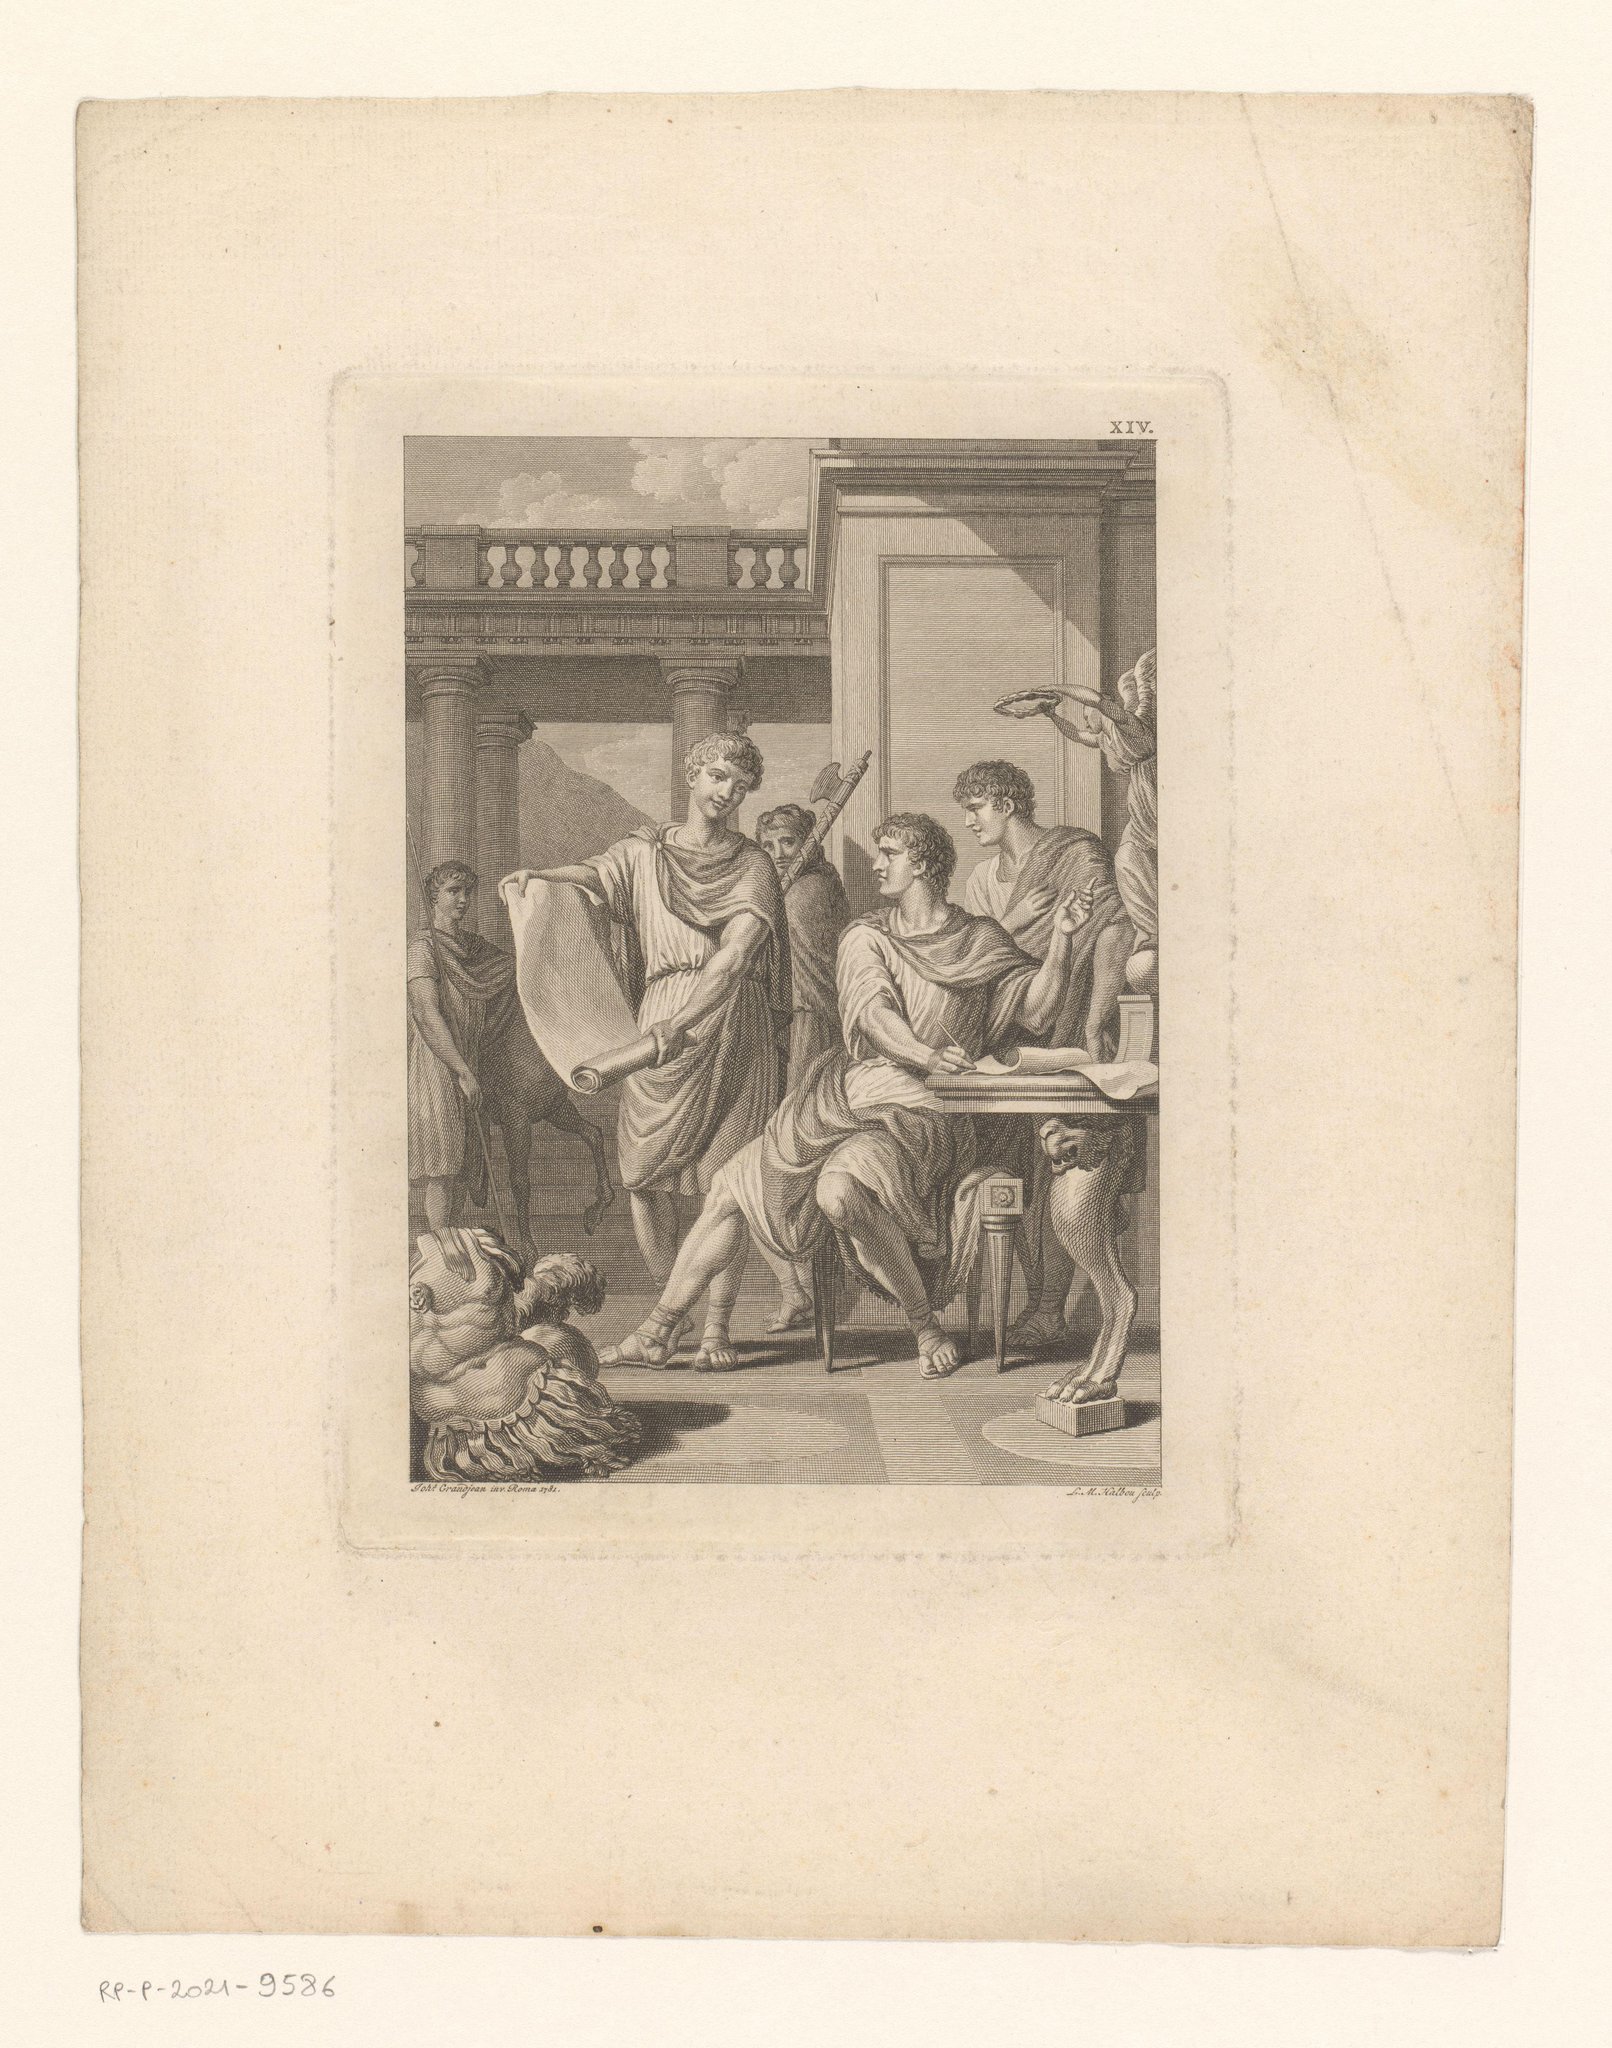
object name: print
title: Germanicus ontrolt een papier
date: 1783-1788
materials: paper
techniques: engraving, etching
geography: france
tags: paper (writing material), (story of) germanicus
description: Volgens Muller werden de prenten uit deze serie door verschillende prentmakers in 1783 gemaakt naar de kleine schilderijen van Grandjean te Rome, en in 1788 uitgegeven. De prent wordt ook ingebonden gevonden in: Winter, Lucretia Wilhelmina van. Germanicus in Zestien Boeken. Amsterdam: Pieter Meijer, 1779.